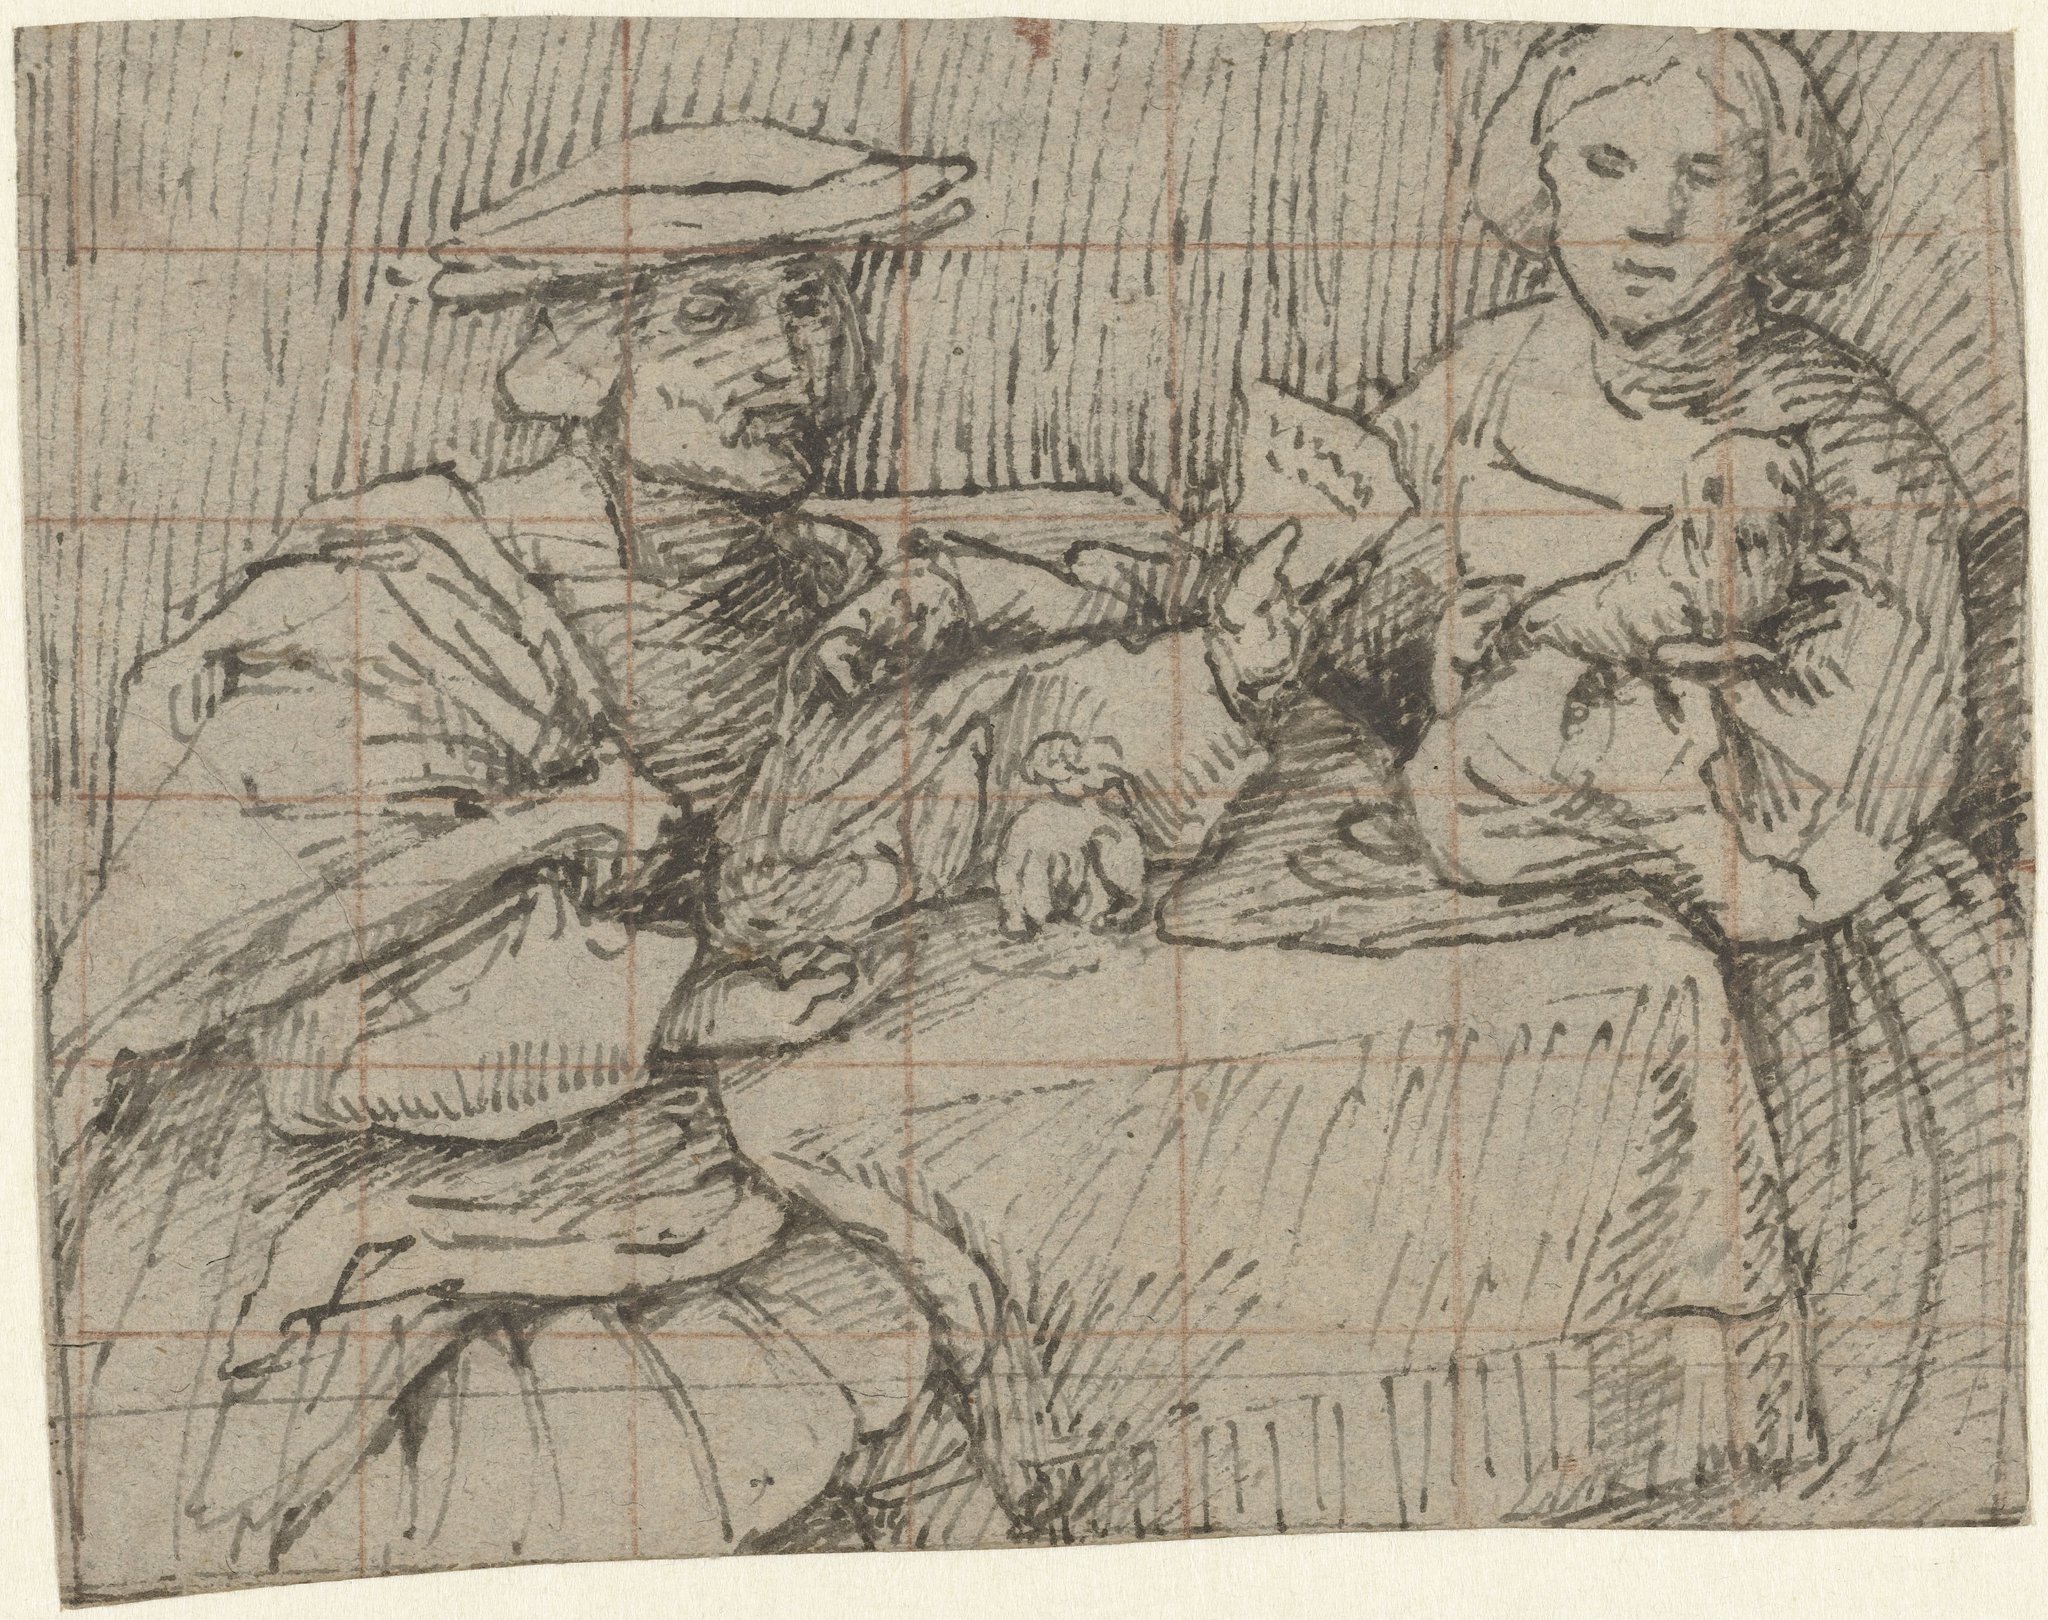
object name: drawing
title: Study of a Married Couple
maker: lorenzo lotto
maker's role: draughtsman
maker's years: 1480-1556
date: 1520-1525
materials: chalk, ink, paper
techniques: pen, drawing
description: Lorenzo Lotto made this swiftly executed sketch preparatory to a painted double portrait, which is now in St Petersburg. He squared the composition for transfer to the canvas. Such working drawings were seldom preserved. This is regrettable, because it is precisely the clothing and attributes chosen by the patrons at this early stage that reveal how they wished to be immortalized.